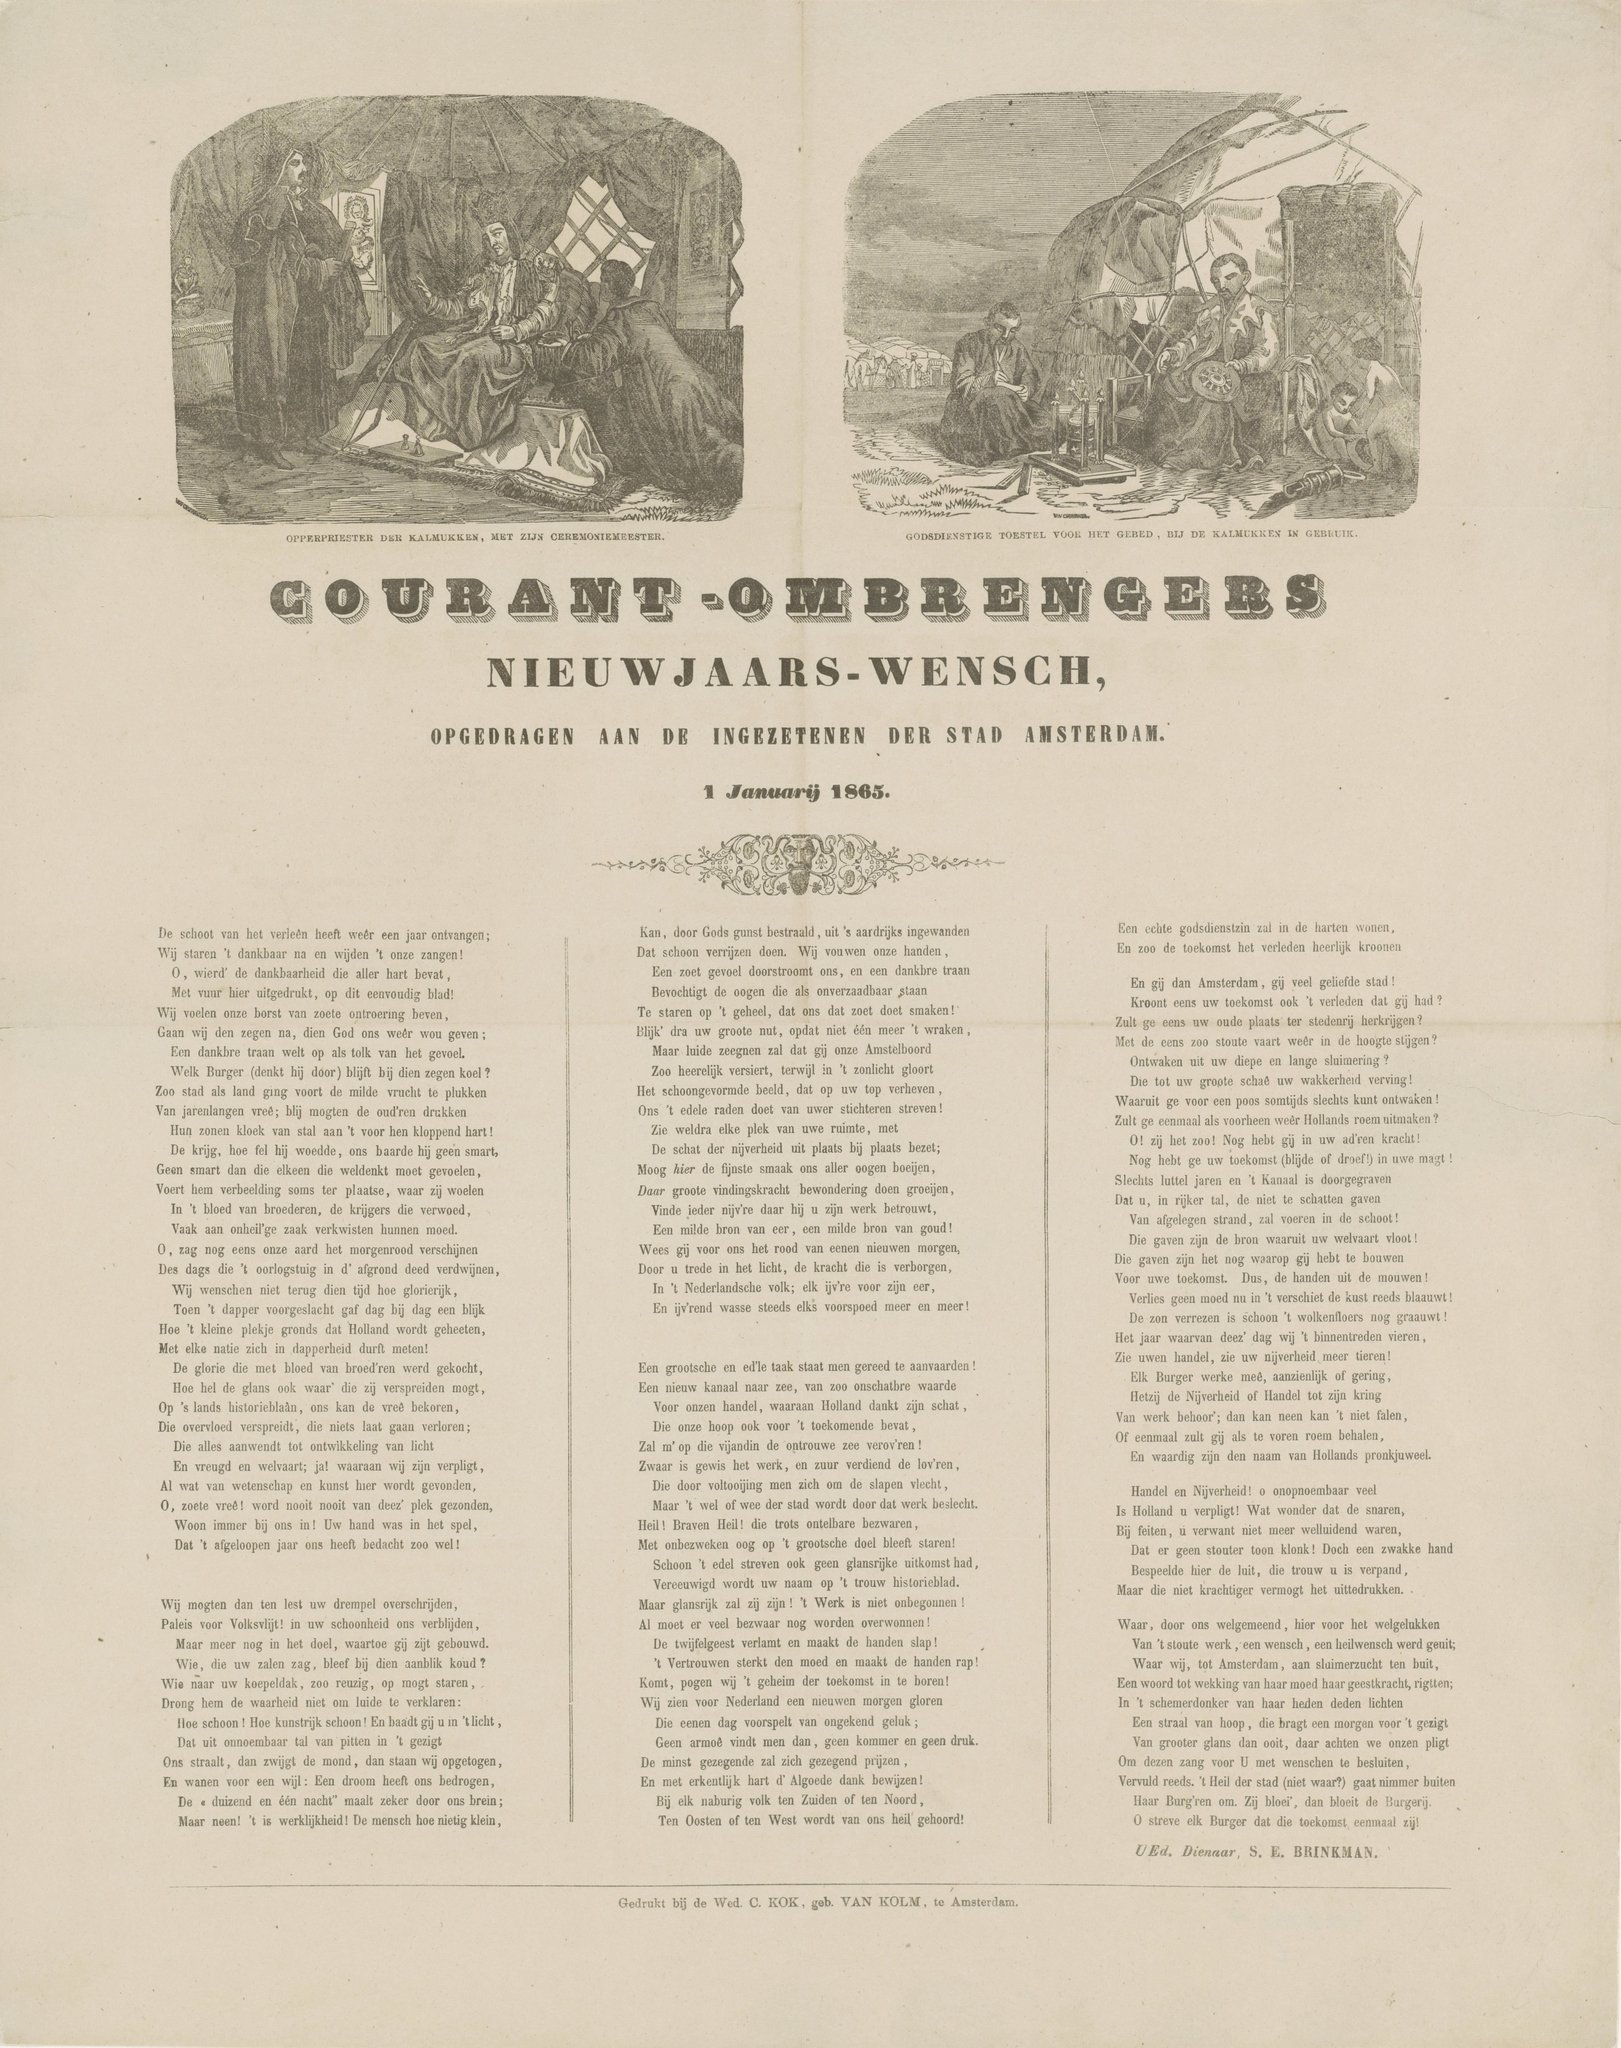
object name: print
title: Nieuwjaarswens van de Amsterdamse courantombrengers voor het jaar 1865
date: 1864-1865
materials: paper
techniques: letterpress printing, engraving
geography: amsterdam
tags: mongolië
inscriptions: collector's mark: Lugt 2228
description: Nieuwjaarswens namens de ombrengers van couranten (krantenbezorgers) te Amsterdam voor het jaar 1865. Bovenaan twee scènes met Kalmukken (in het huidige Mongolië), aan boeken ontleend. Onderaan een gedicht in drie kolommen. Van de courantombrenger: S.E. Brinkman.